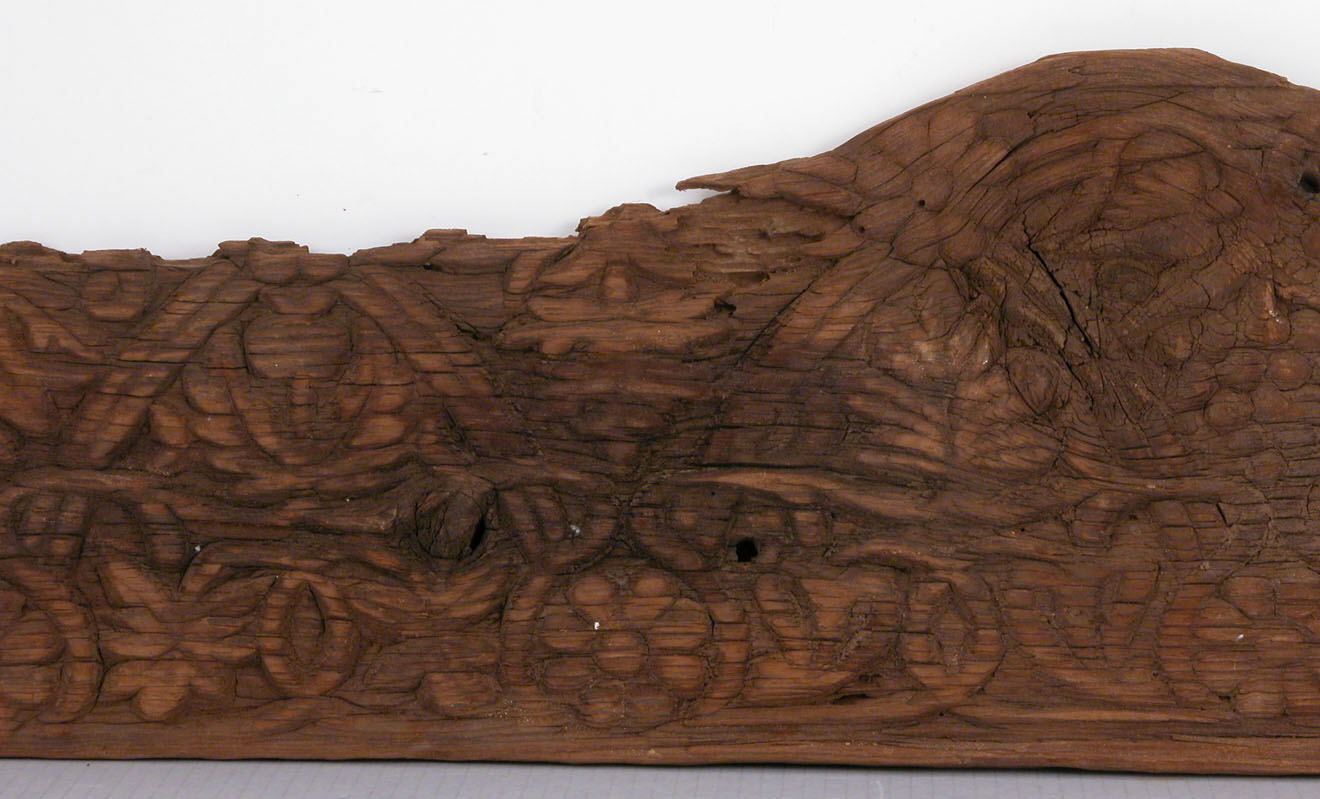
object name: panel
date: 601-800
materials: wood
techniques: carving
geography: egypt